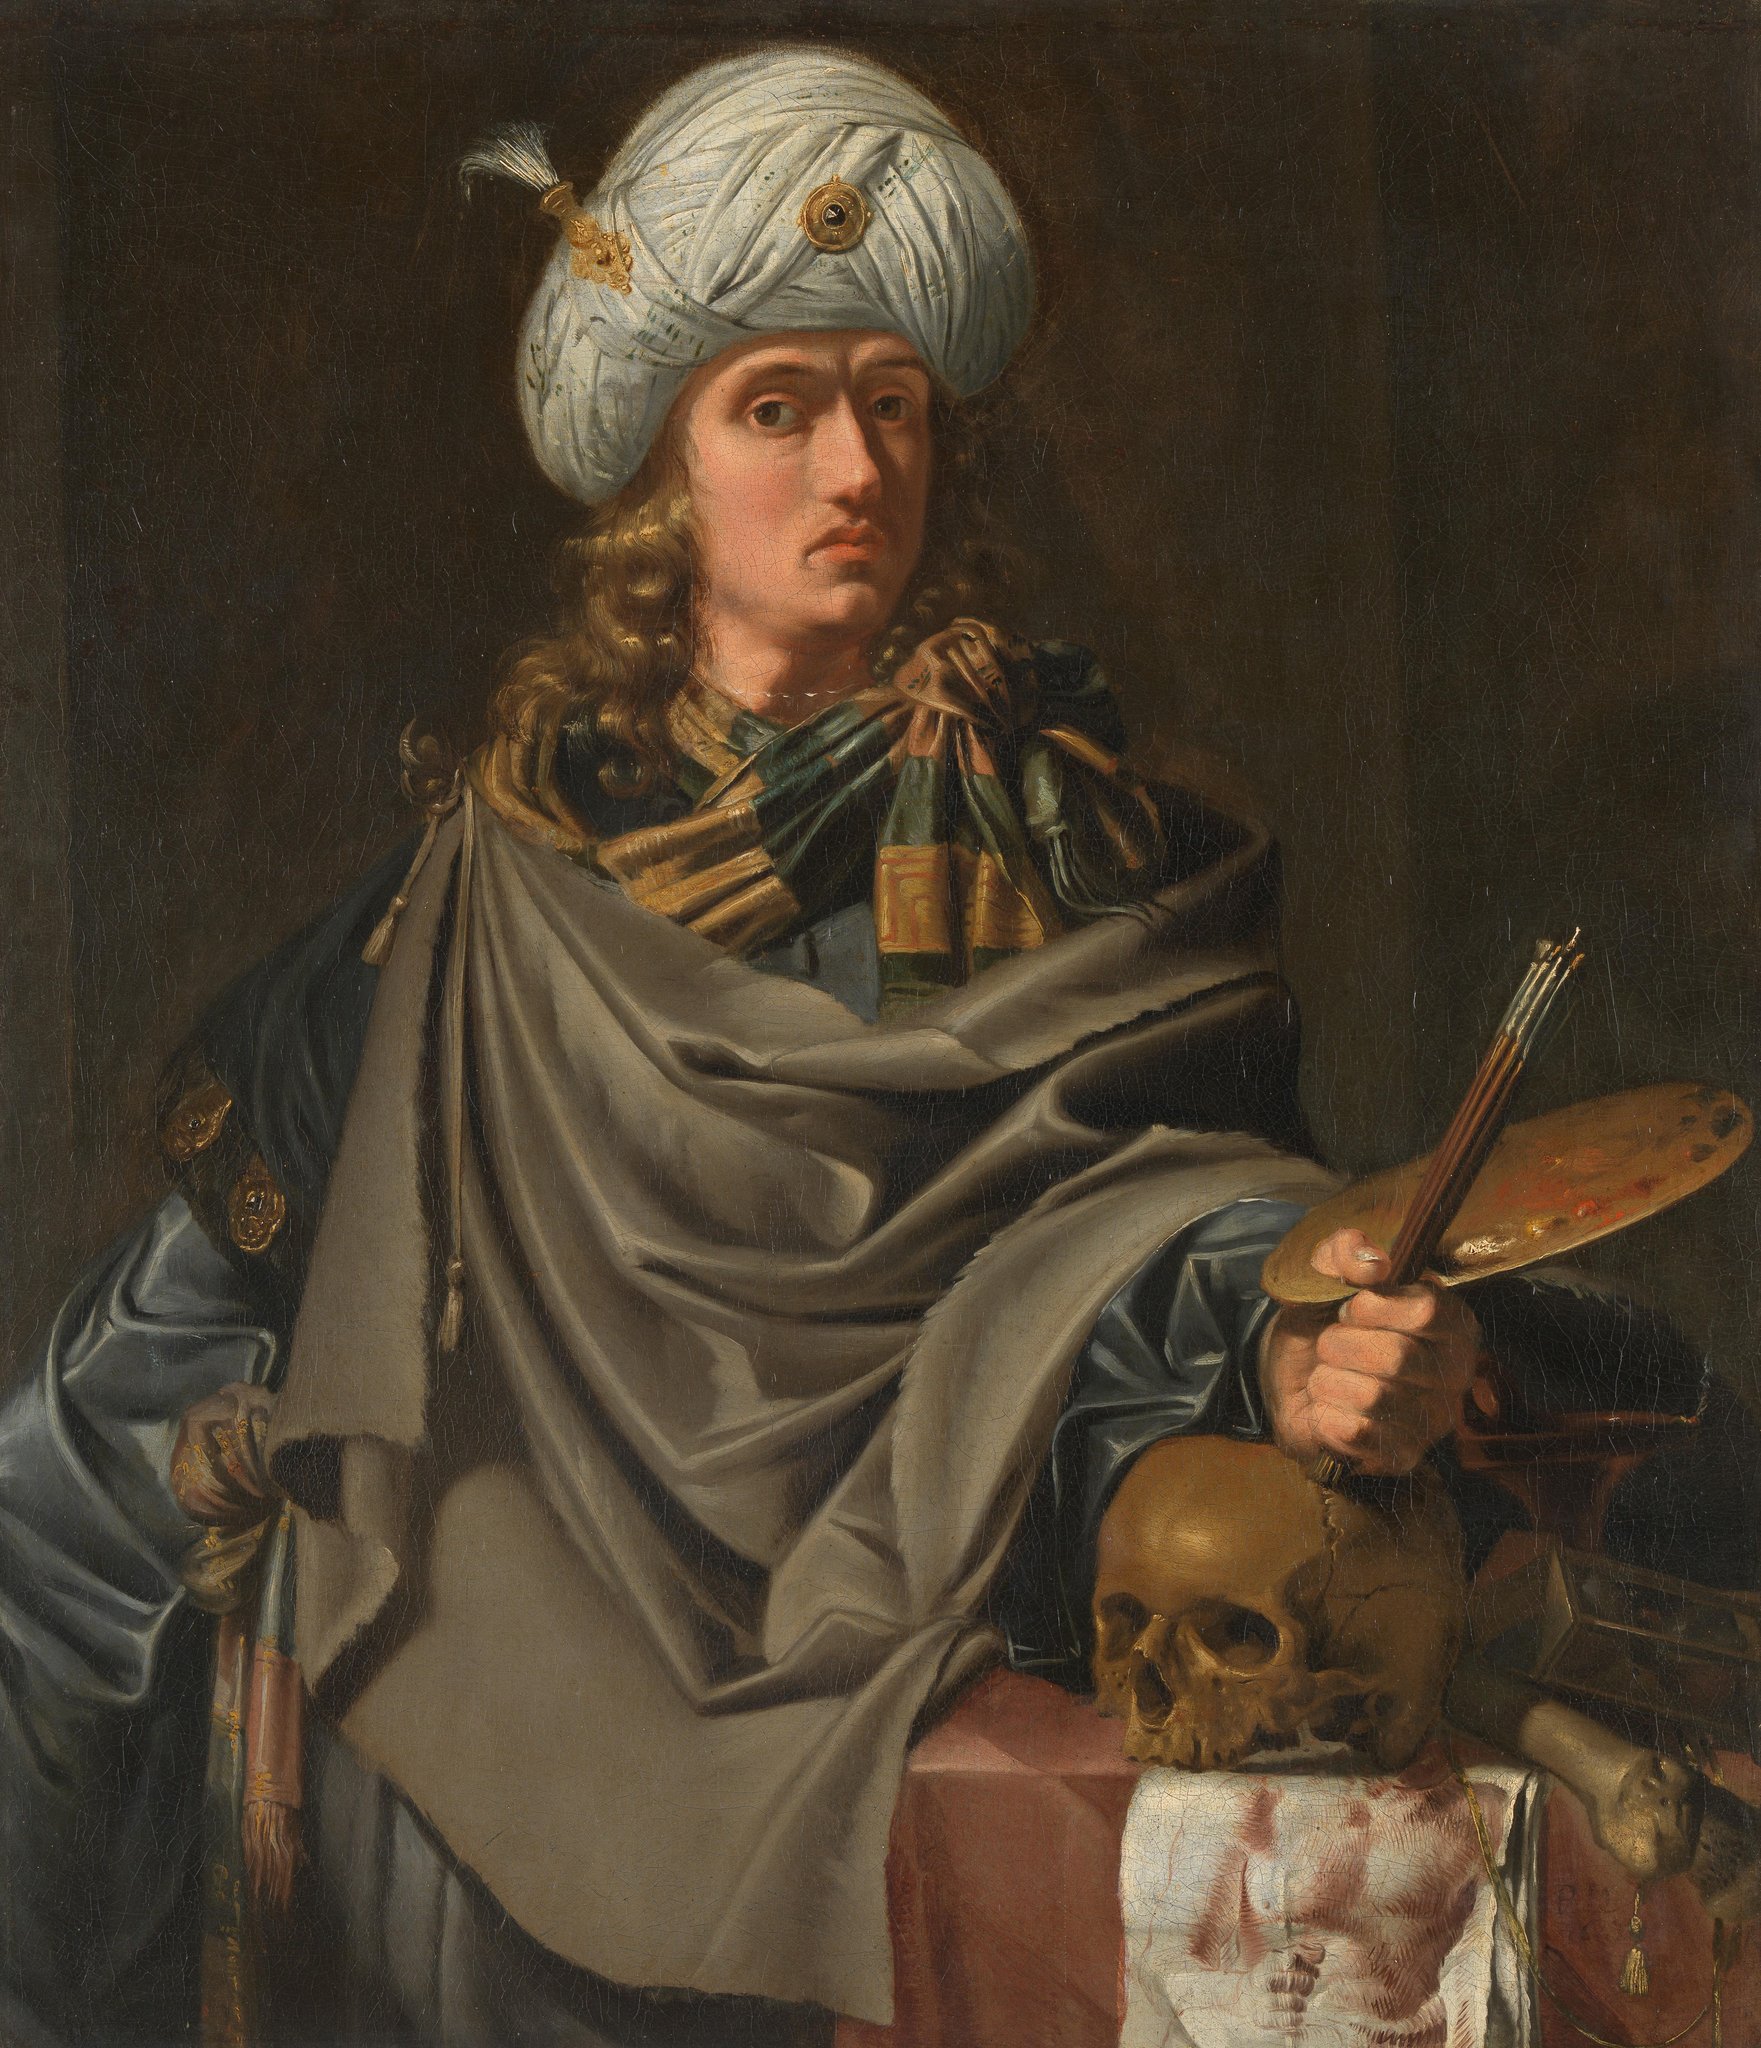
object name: painting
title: Self portrait?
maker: johannes van swinderen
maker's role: painter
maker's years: 1594-1636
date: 1628-1636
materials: canvas, oil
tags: head-gear: turban, portrait, self-portrait of painter, portrait, self-portrait of artist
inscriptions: signature and date, lower right (false; D and G ligated): ‘P. DG 1647’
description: Zelfportret van de schilder Johannes van Swinderen in Oosters gewaad. In de rechterhand palet en penselen rustend op een schedel en een anatomische tekening.